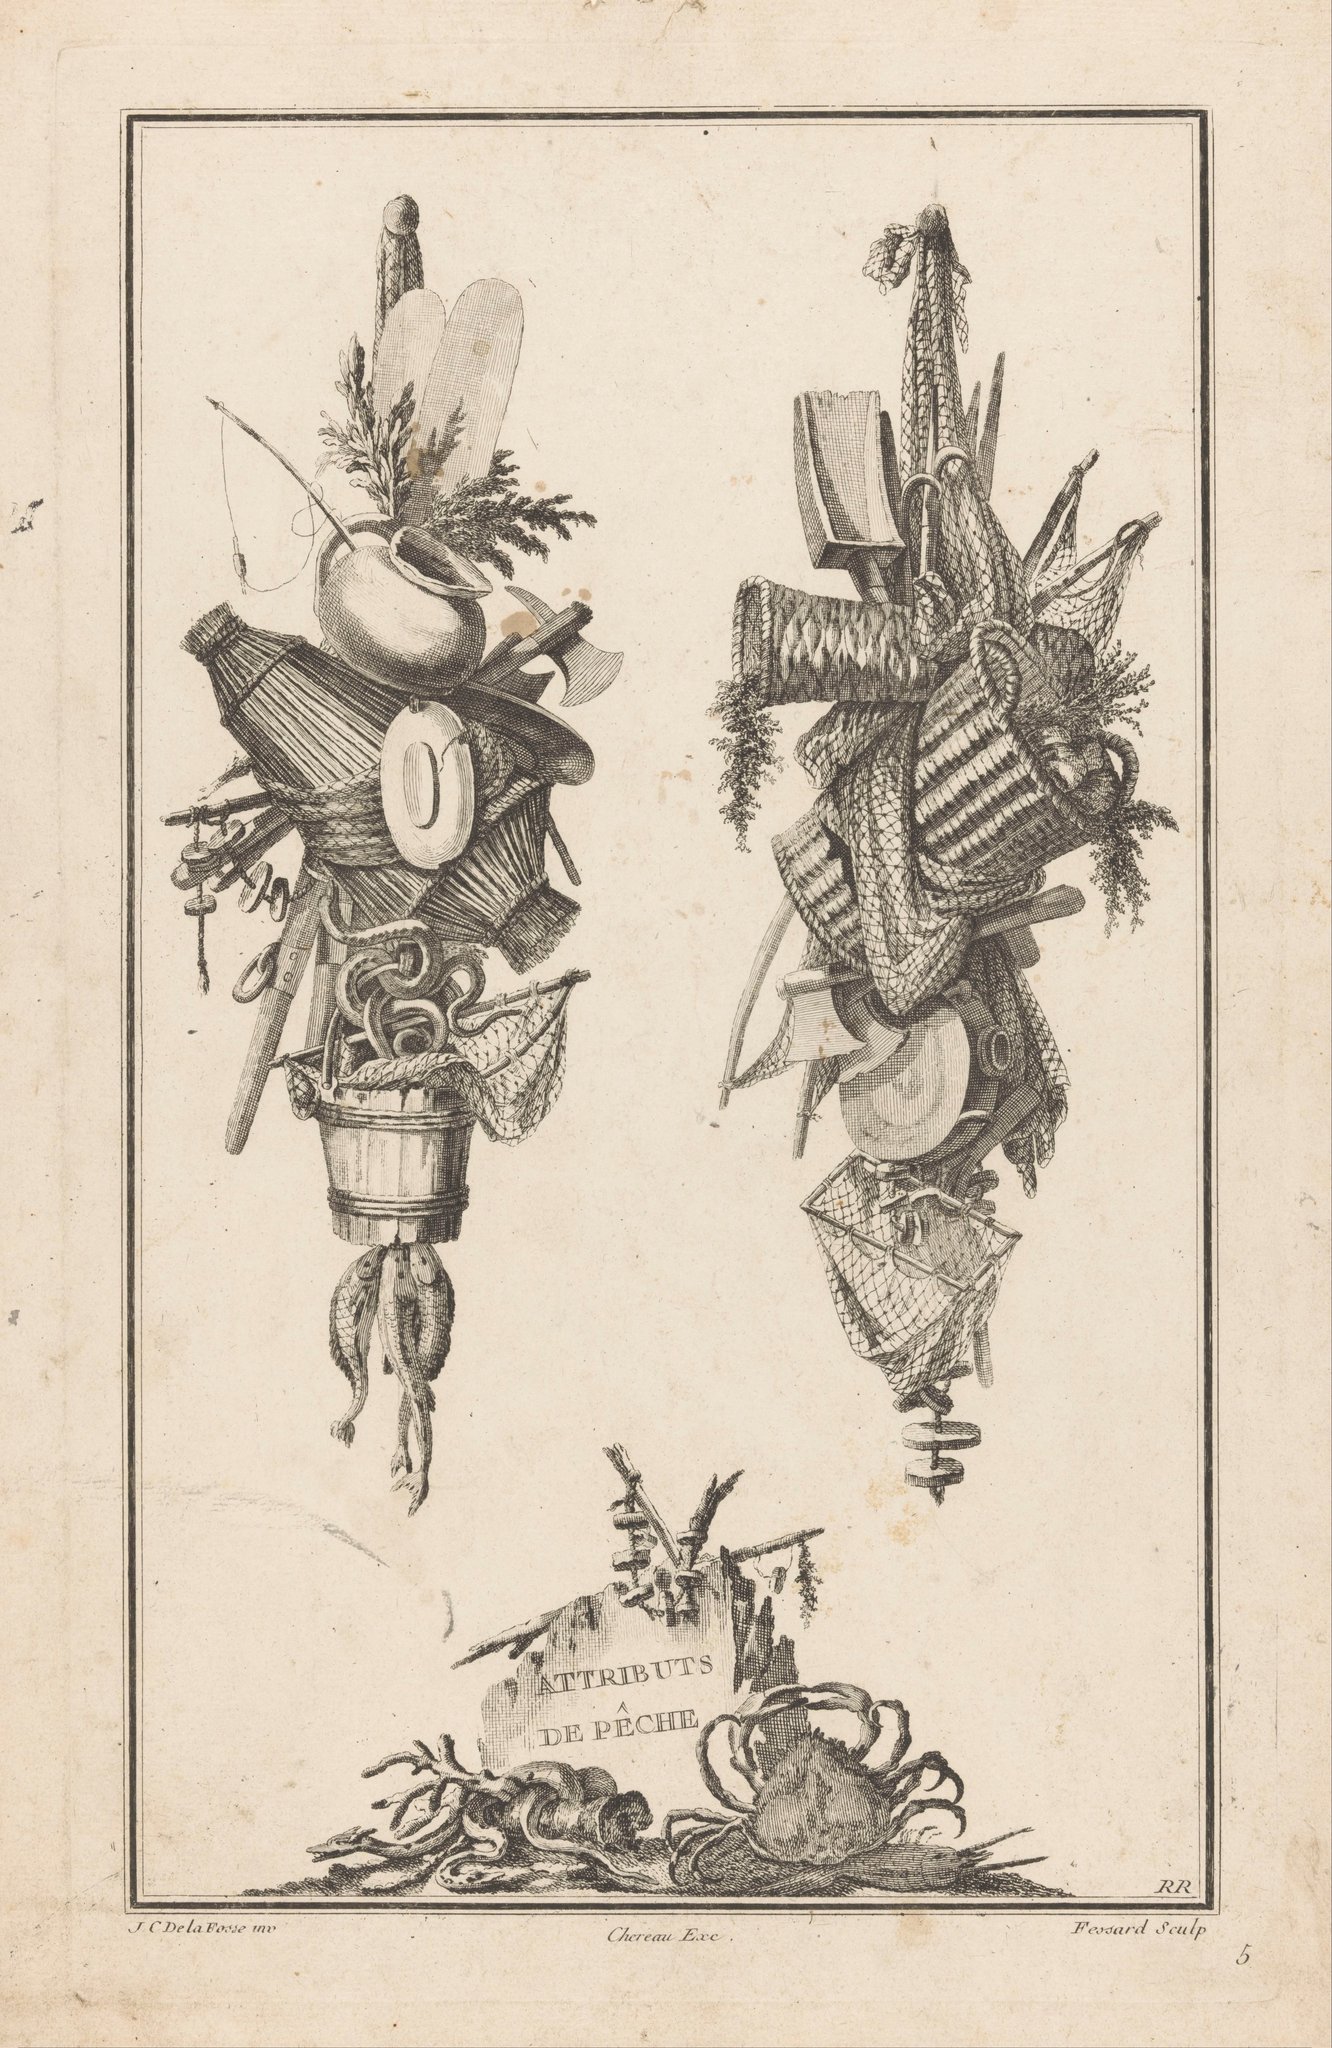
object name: print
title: 37e Cahier RR Livre De Trophées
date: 1771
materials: paper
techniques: engraving, etching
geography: paris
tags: trophy, i.e.: decorative arrangement of symbolic or typical objects ~ ornament, fishing (sports)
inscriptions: collector's mark: Lugt 2760, collector's mark: Lugt 2228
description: Links een trofee met een vaas, een bijl, een fuik en een emmer met een net en palingen. Rechts een trofee met netten, manden en bijlen.